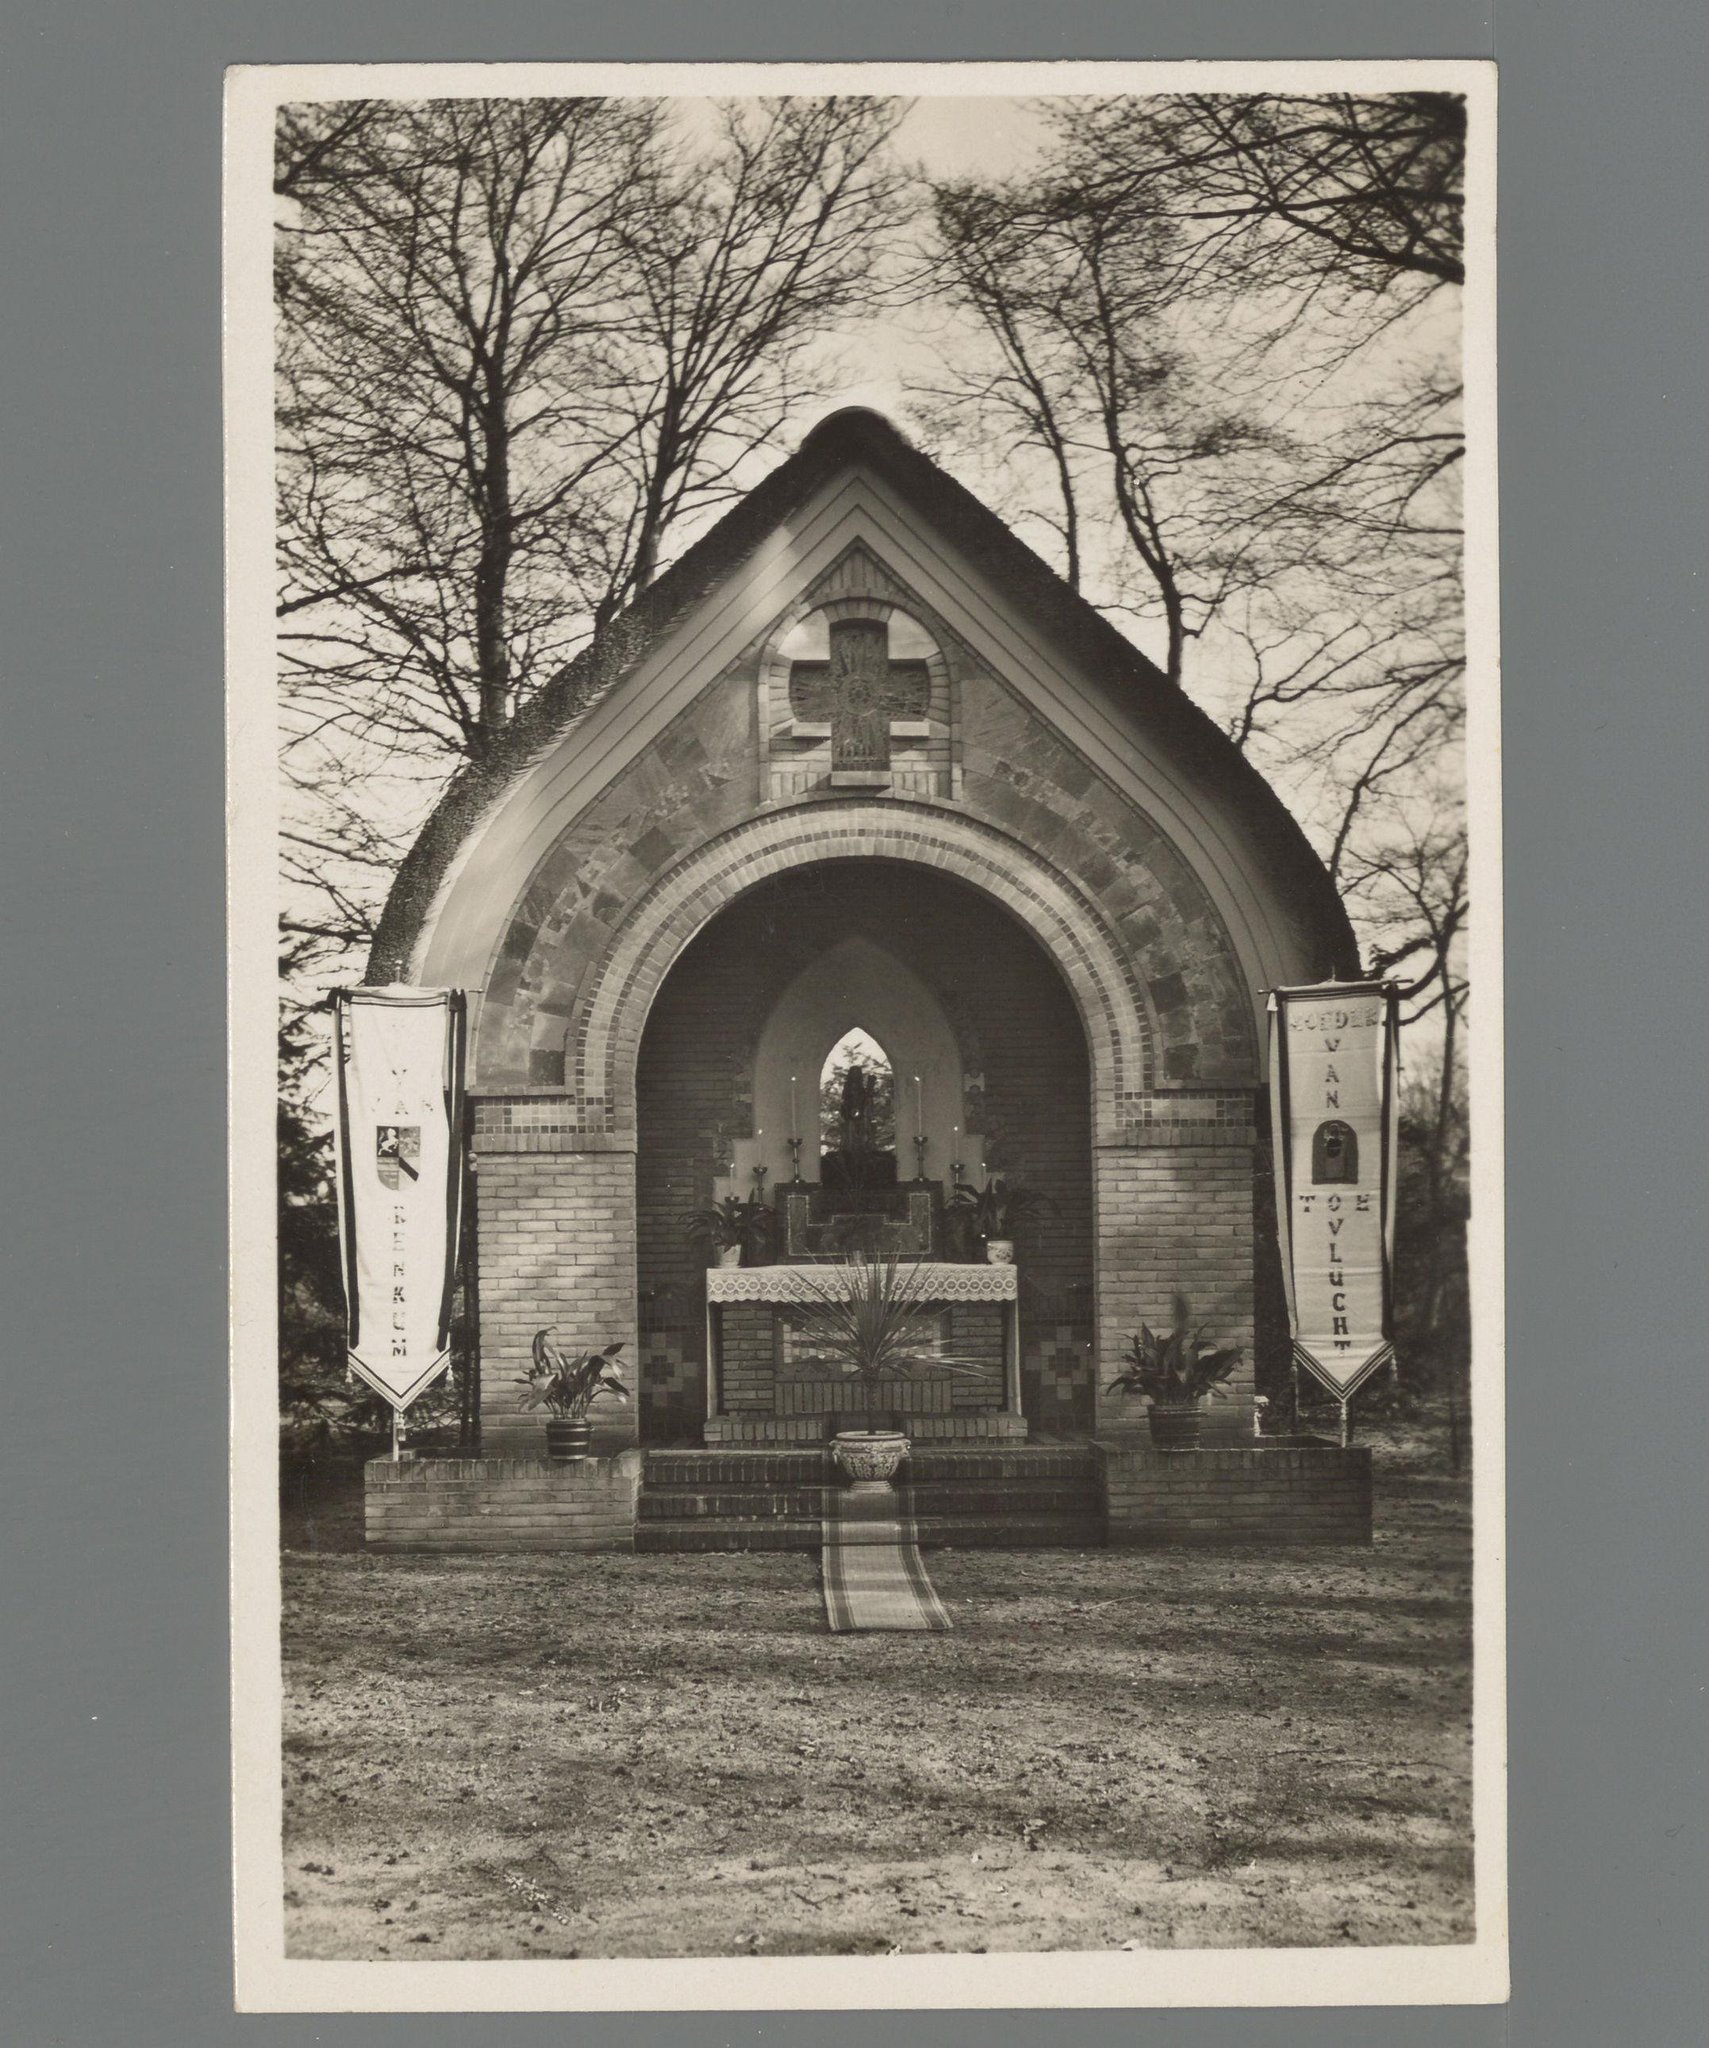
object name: ansichtkaart, prentbriefkaart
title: Kapel. Processie park O. L. Vrouw van Renkum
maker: Anonymous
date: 1903-1939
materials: paper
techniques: gelatin silver print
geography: renkum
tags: church (exterior) - qq - small church, chapel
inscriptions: date